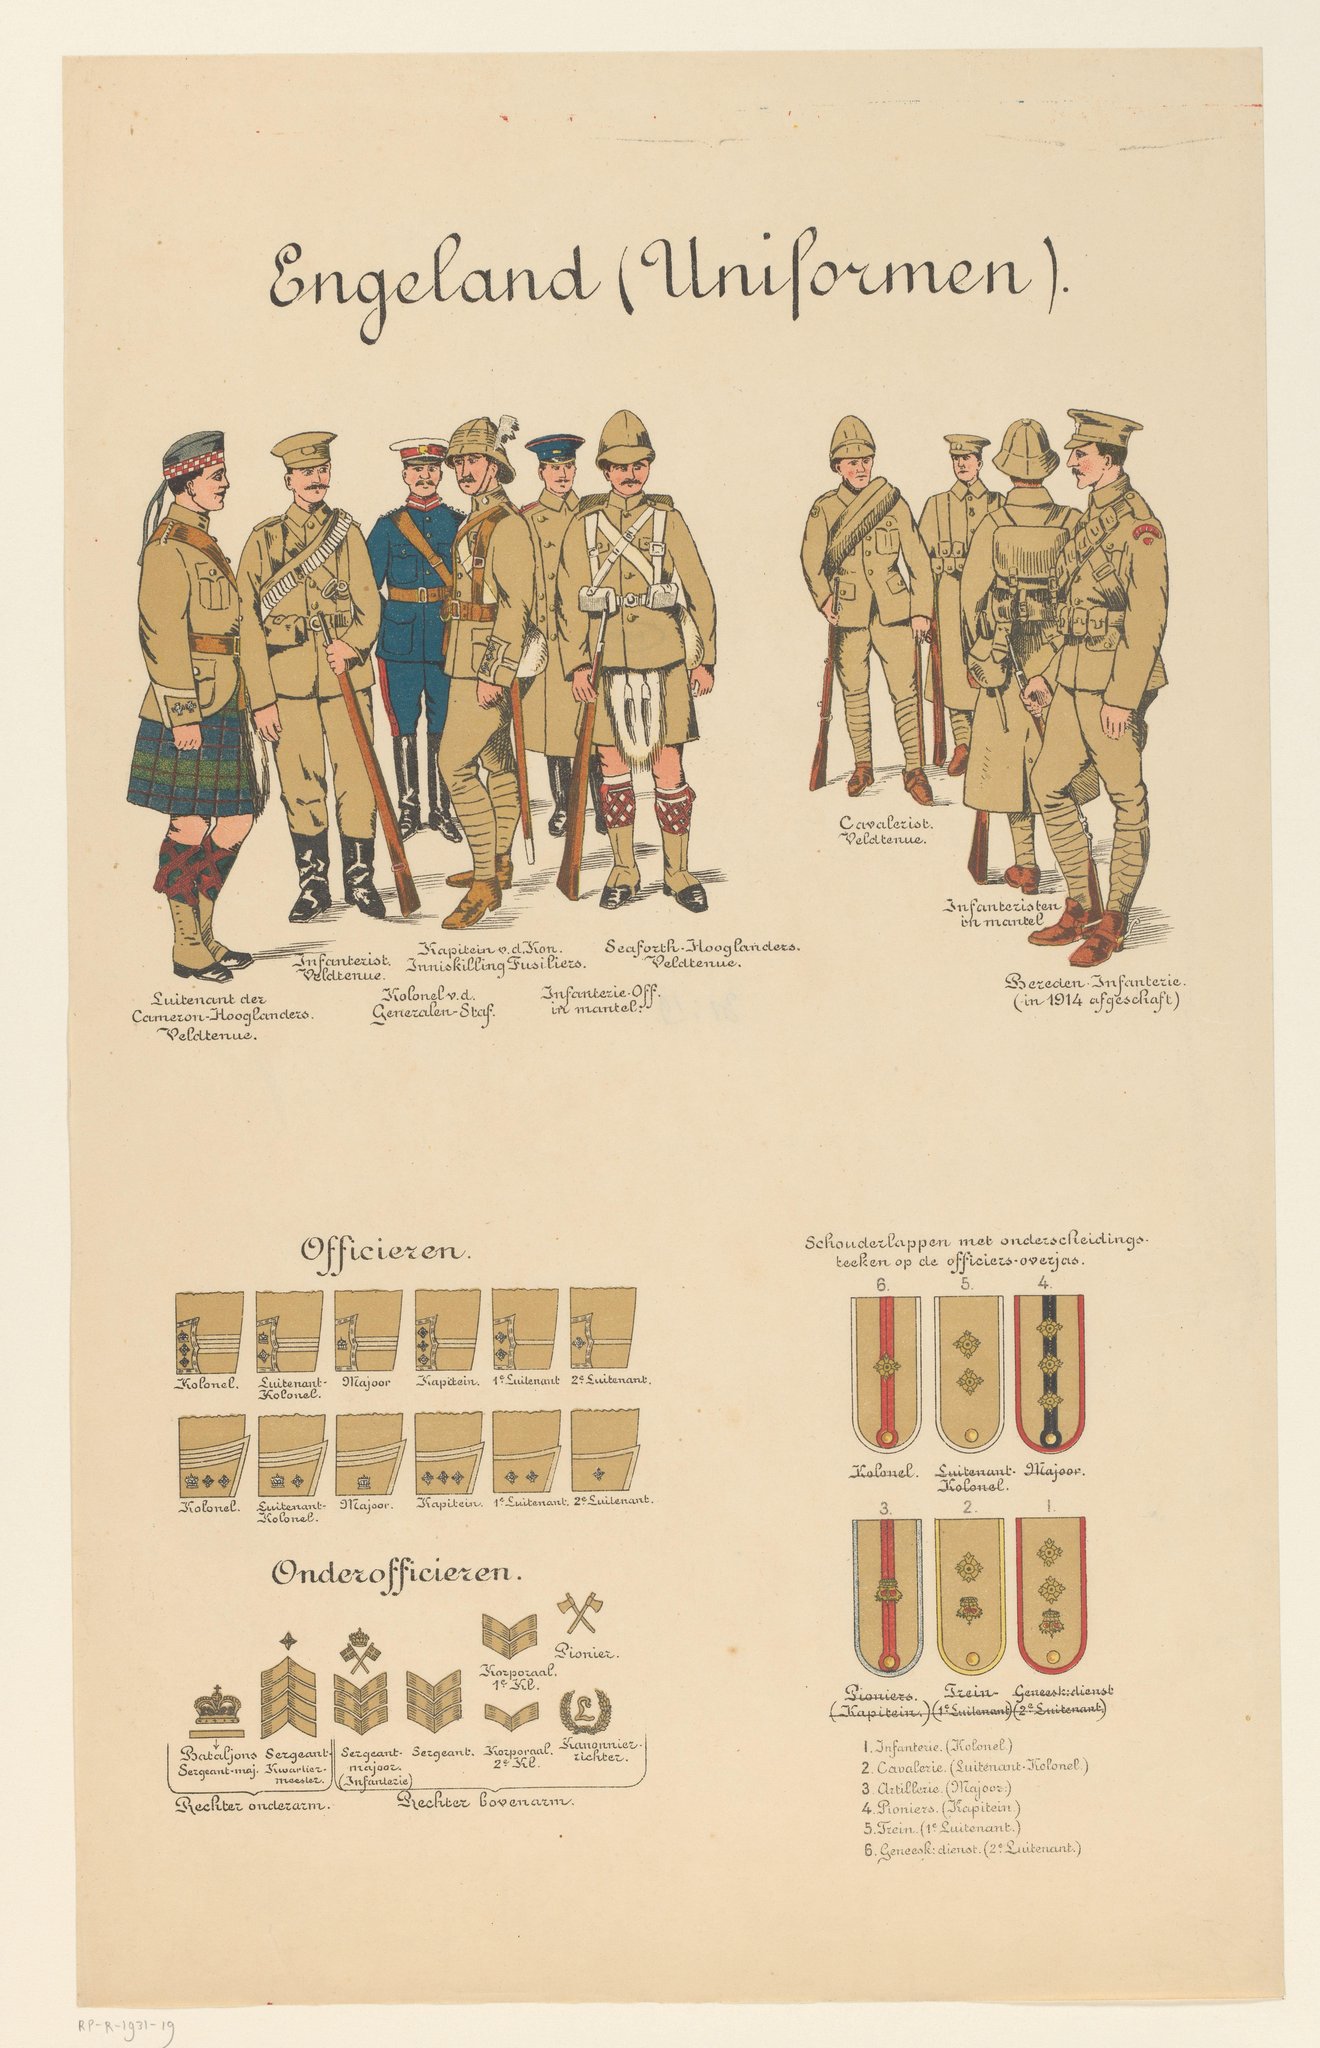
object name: print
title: Engeland (Uniformen)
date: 1914-1918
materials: paper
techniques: color autotype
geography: netherlands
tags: (military) uniforms, great britain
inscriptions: collector's mark: Lugt 2228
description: Overzicht van uniformen van het Britse leger tijdens de Eerste Wereldoorlog.